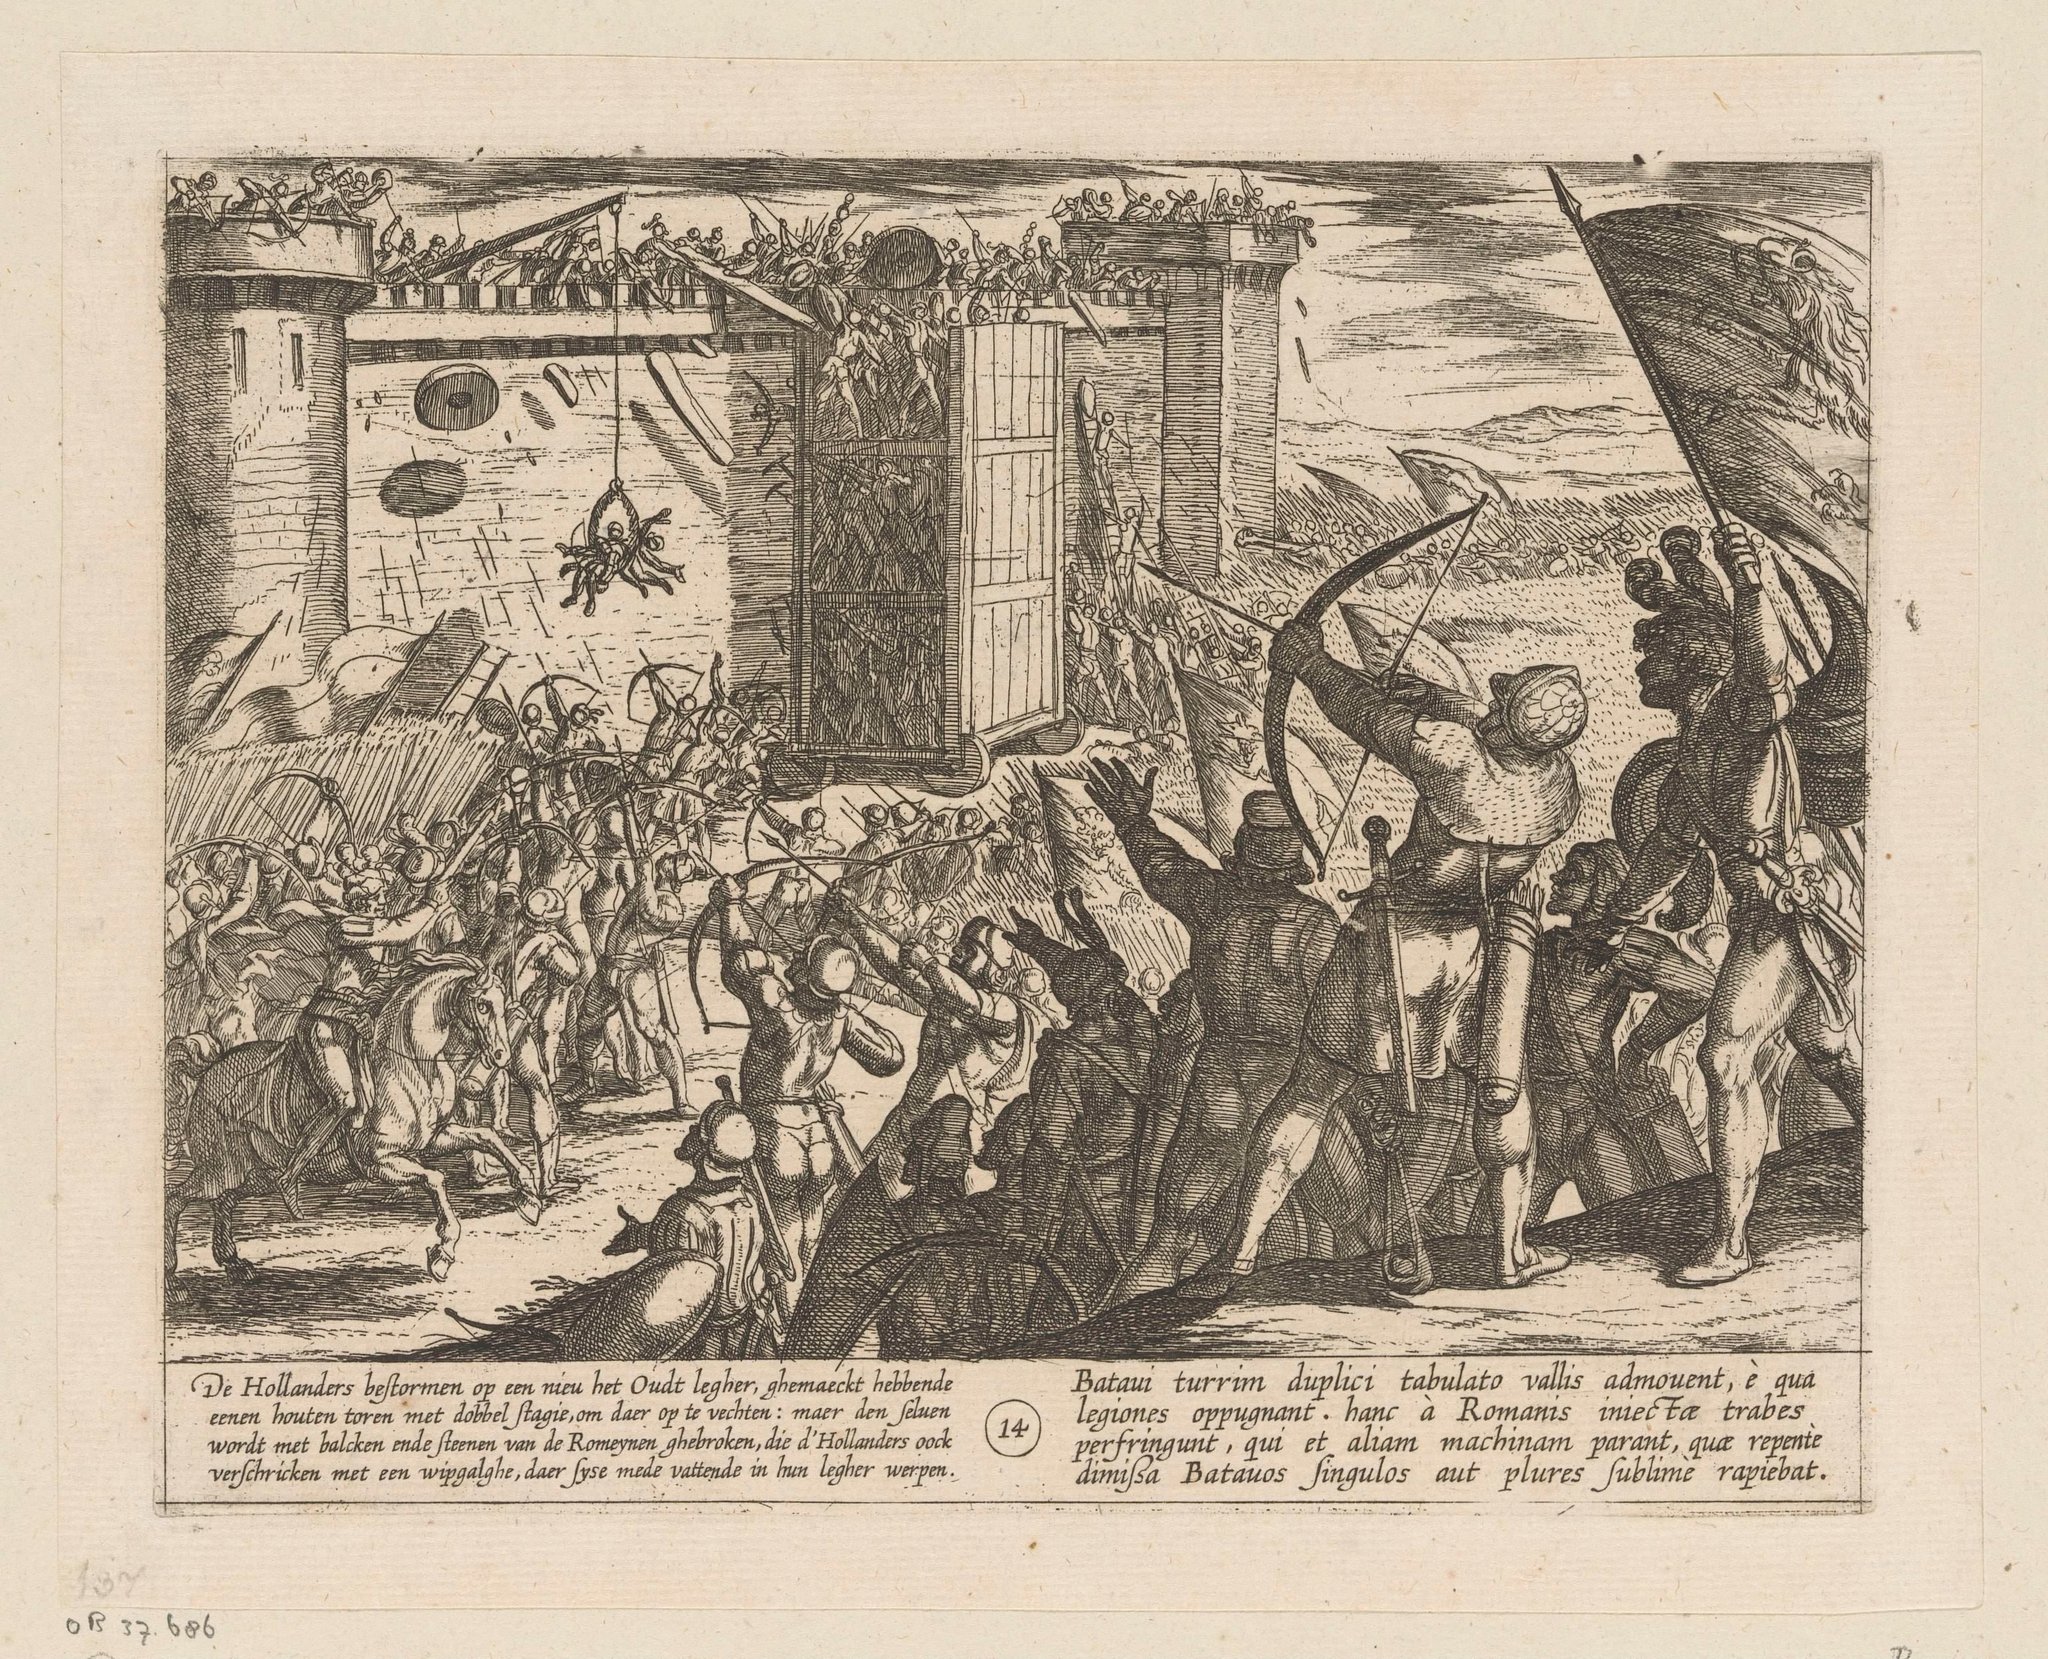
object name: print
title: De Bataafse Opstand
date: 1612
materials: paper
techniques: etching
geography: italy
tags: battle, fighting in general, extinct, 'historical' peoples (with name), netherlands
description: Een nieuwe aanval op een Romeinse vesting waarbij gebruik wordt gemaakt van een houten toren. Prent nummer 14 in de serie prenten over de Bataafse Opstand: Batavorum cum Romanis bellum / à Corn. Tacito lib. IV & V. : Hist. olim descriptum, figuris nunc aeneis expressum, auctore Othone Vaenio Lugdunobatava = De Batavische oft oude Hollandtsche oorloghe teghen de Romeynen. Otto Vaenius, Antwerpen 1612. Onderaan twee verzen van vier regels in het Nederlands en in het Latijn. Zonder tekst op achterzijde.